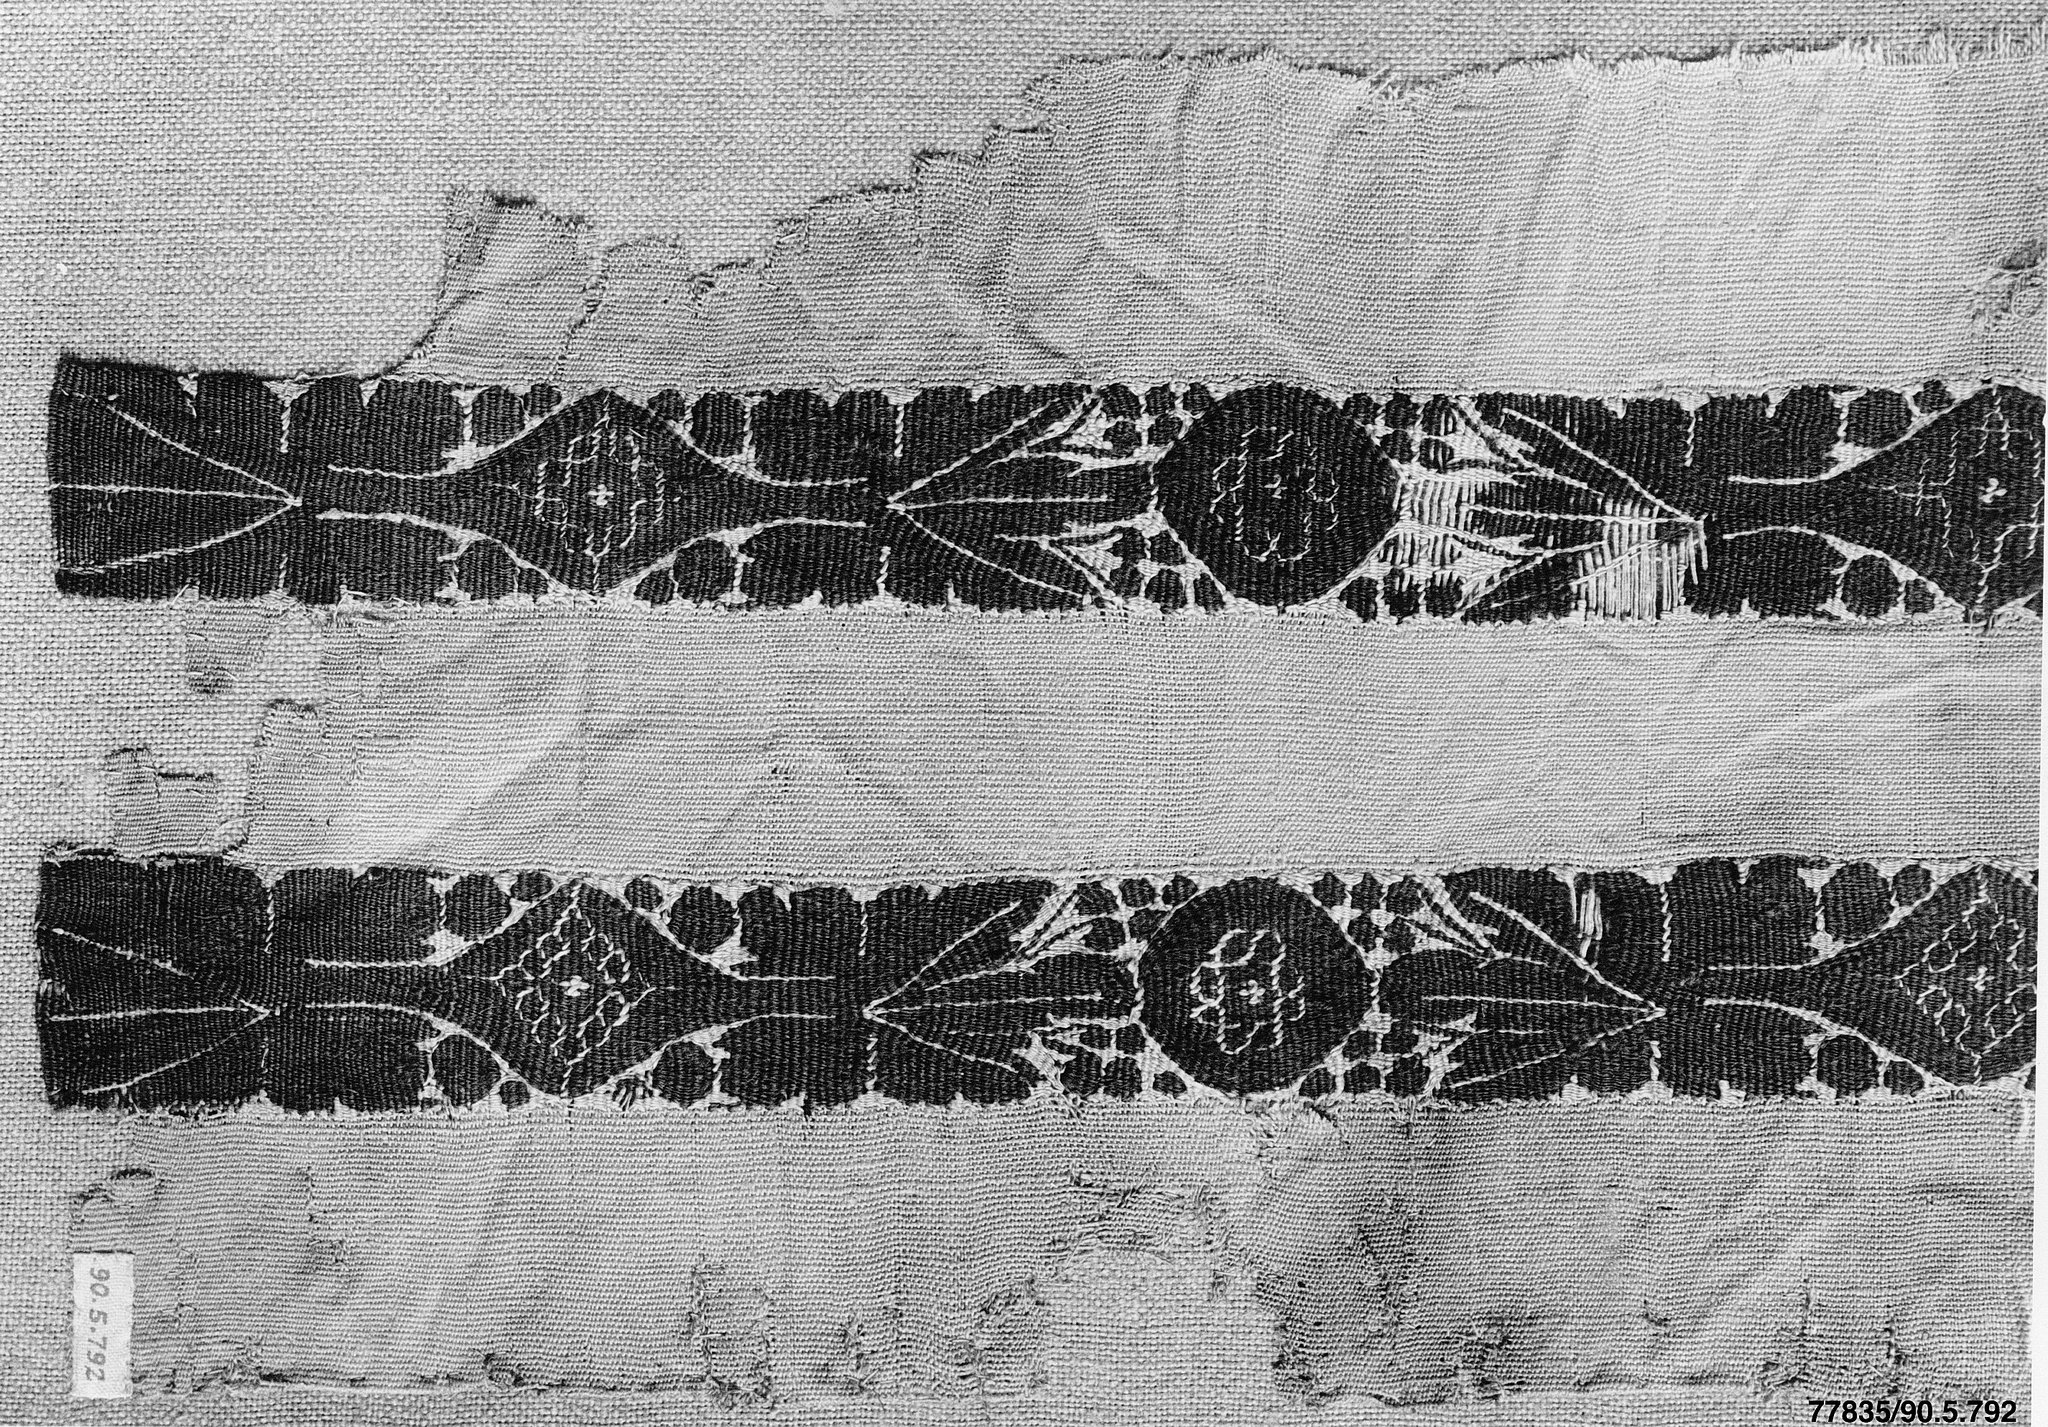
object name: textile fragment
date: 201-400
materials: linen, wool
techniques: weave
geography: egypt